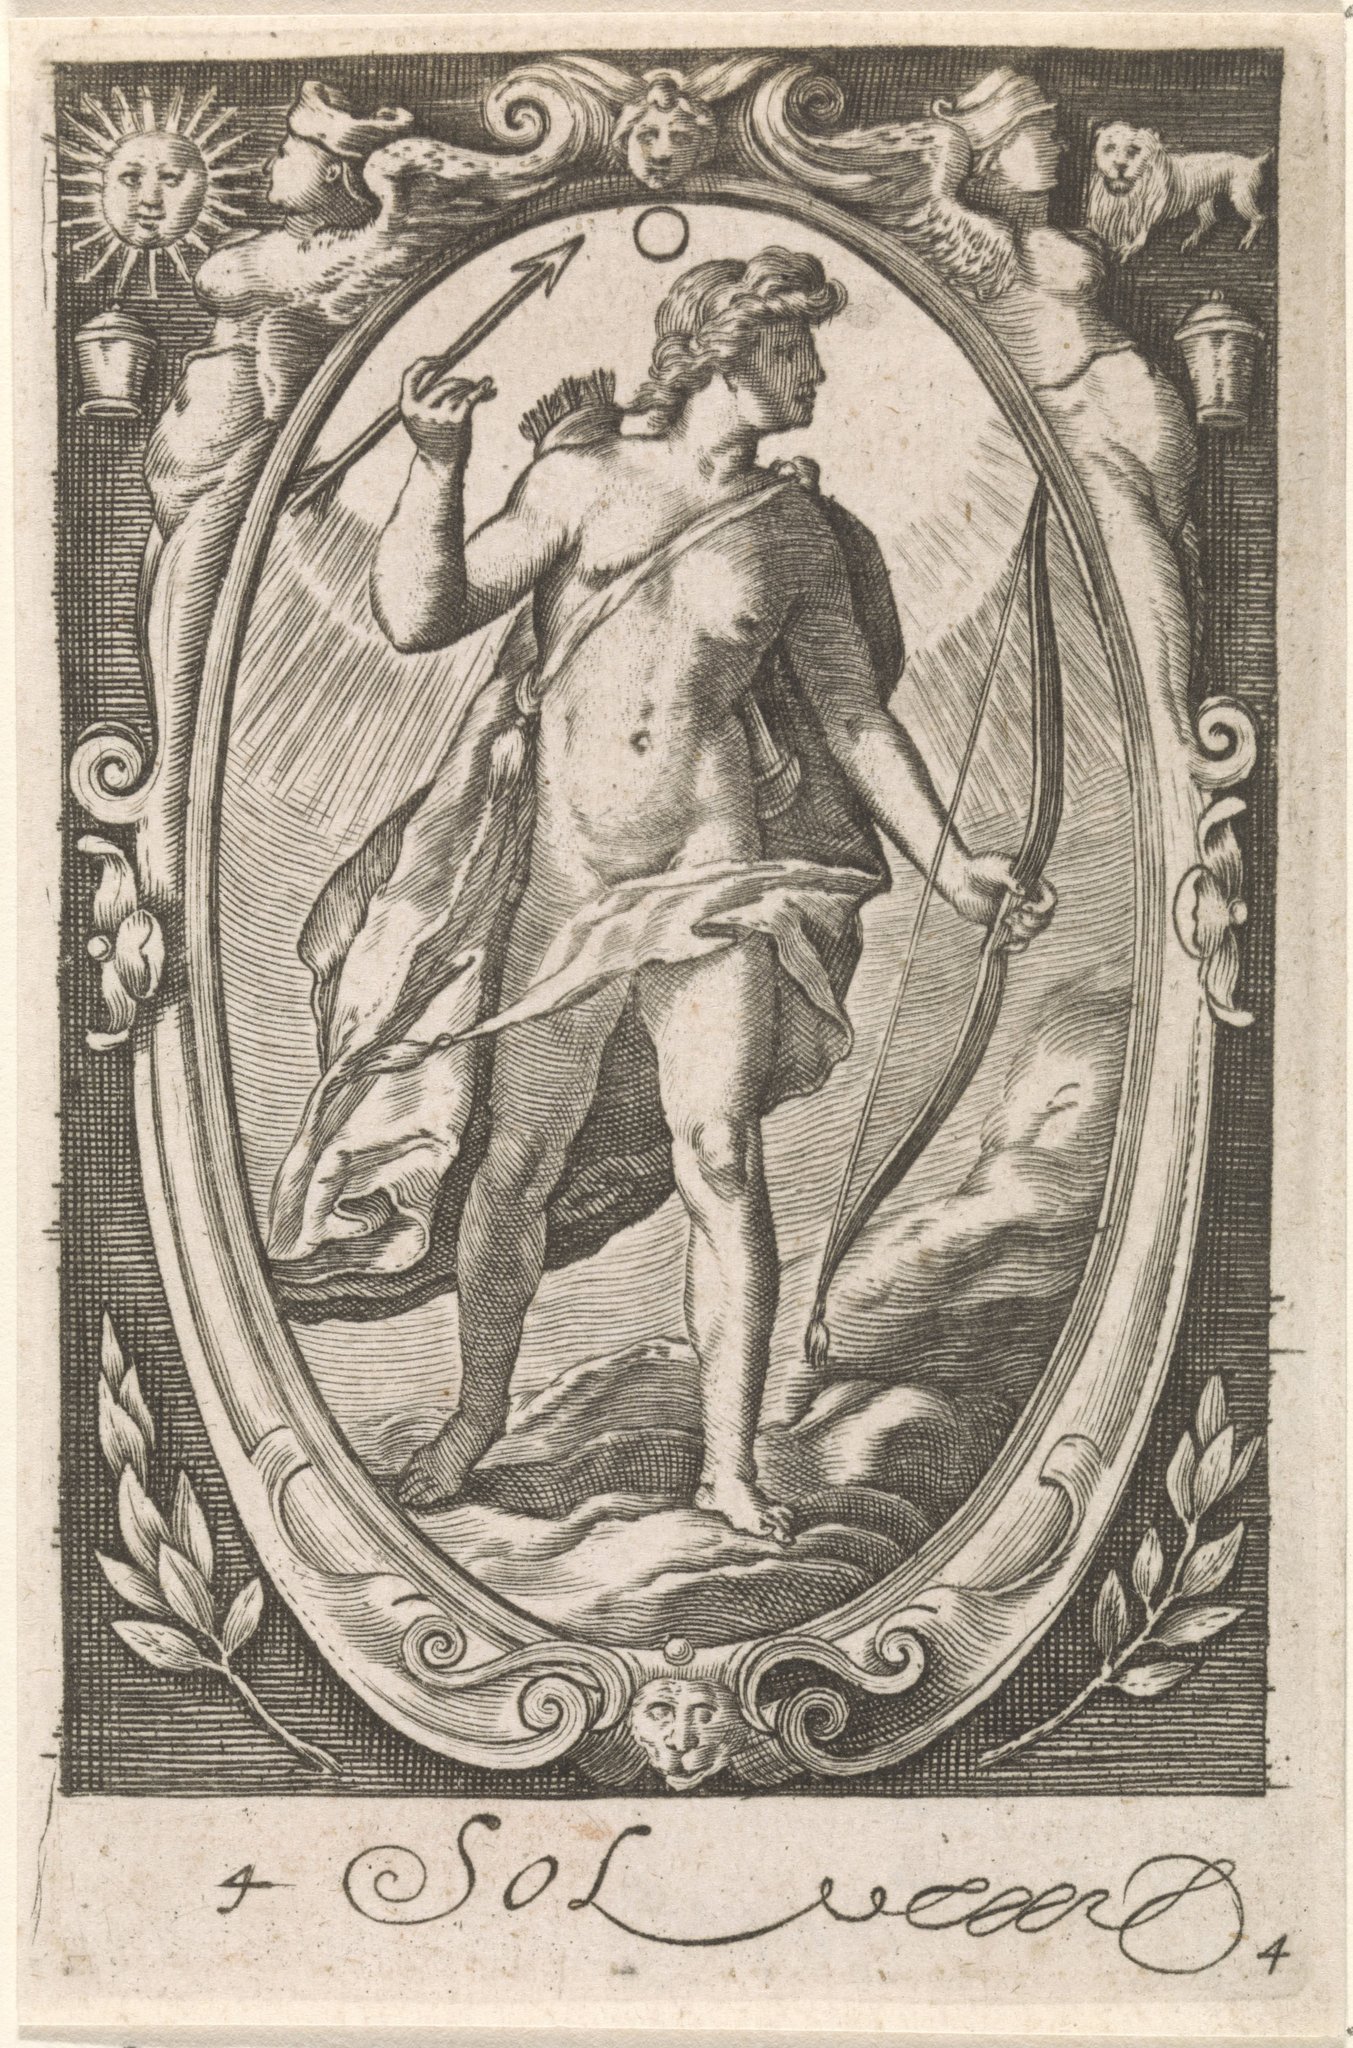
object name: print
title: De zeven planeten serie B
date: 1597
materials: paper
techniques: engraving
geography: amsterdam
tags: apollo as sun-god, i.e. sol (helius), titan, sol and his children ('planetenkinder')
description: Apollo, of de gepersonifieerde zon, met pijl en boog. Boven zijn hoofd het astronomische symbool voor zijn planeet. Staand in een ovaal cartouche met bovenaan de twee tekenen: Zon en Leeuw.